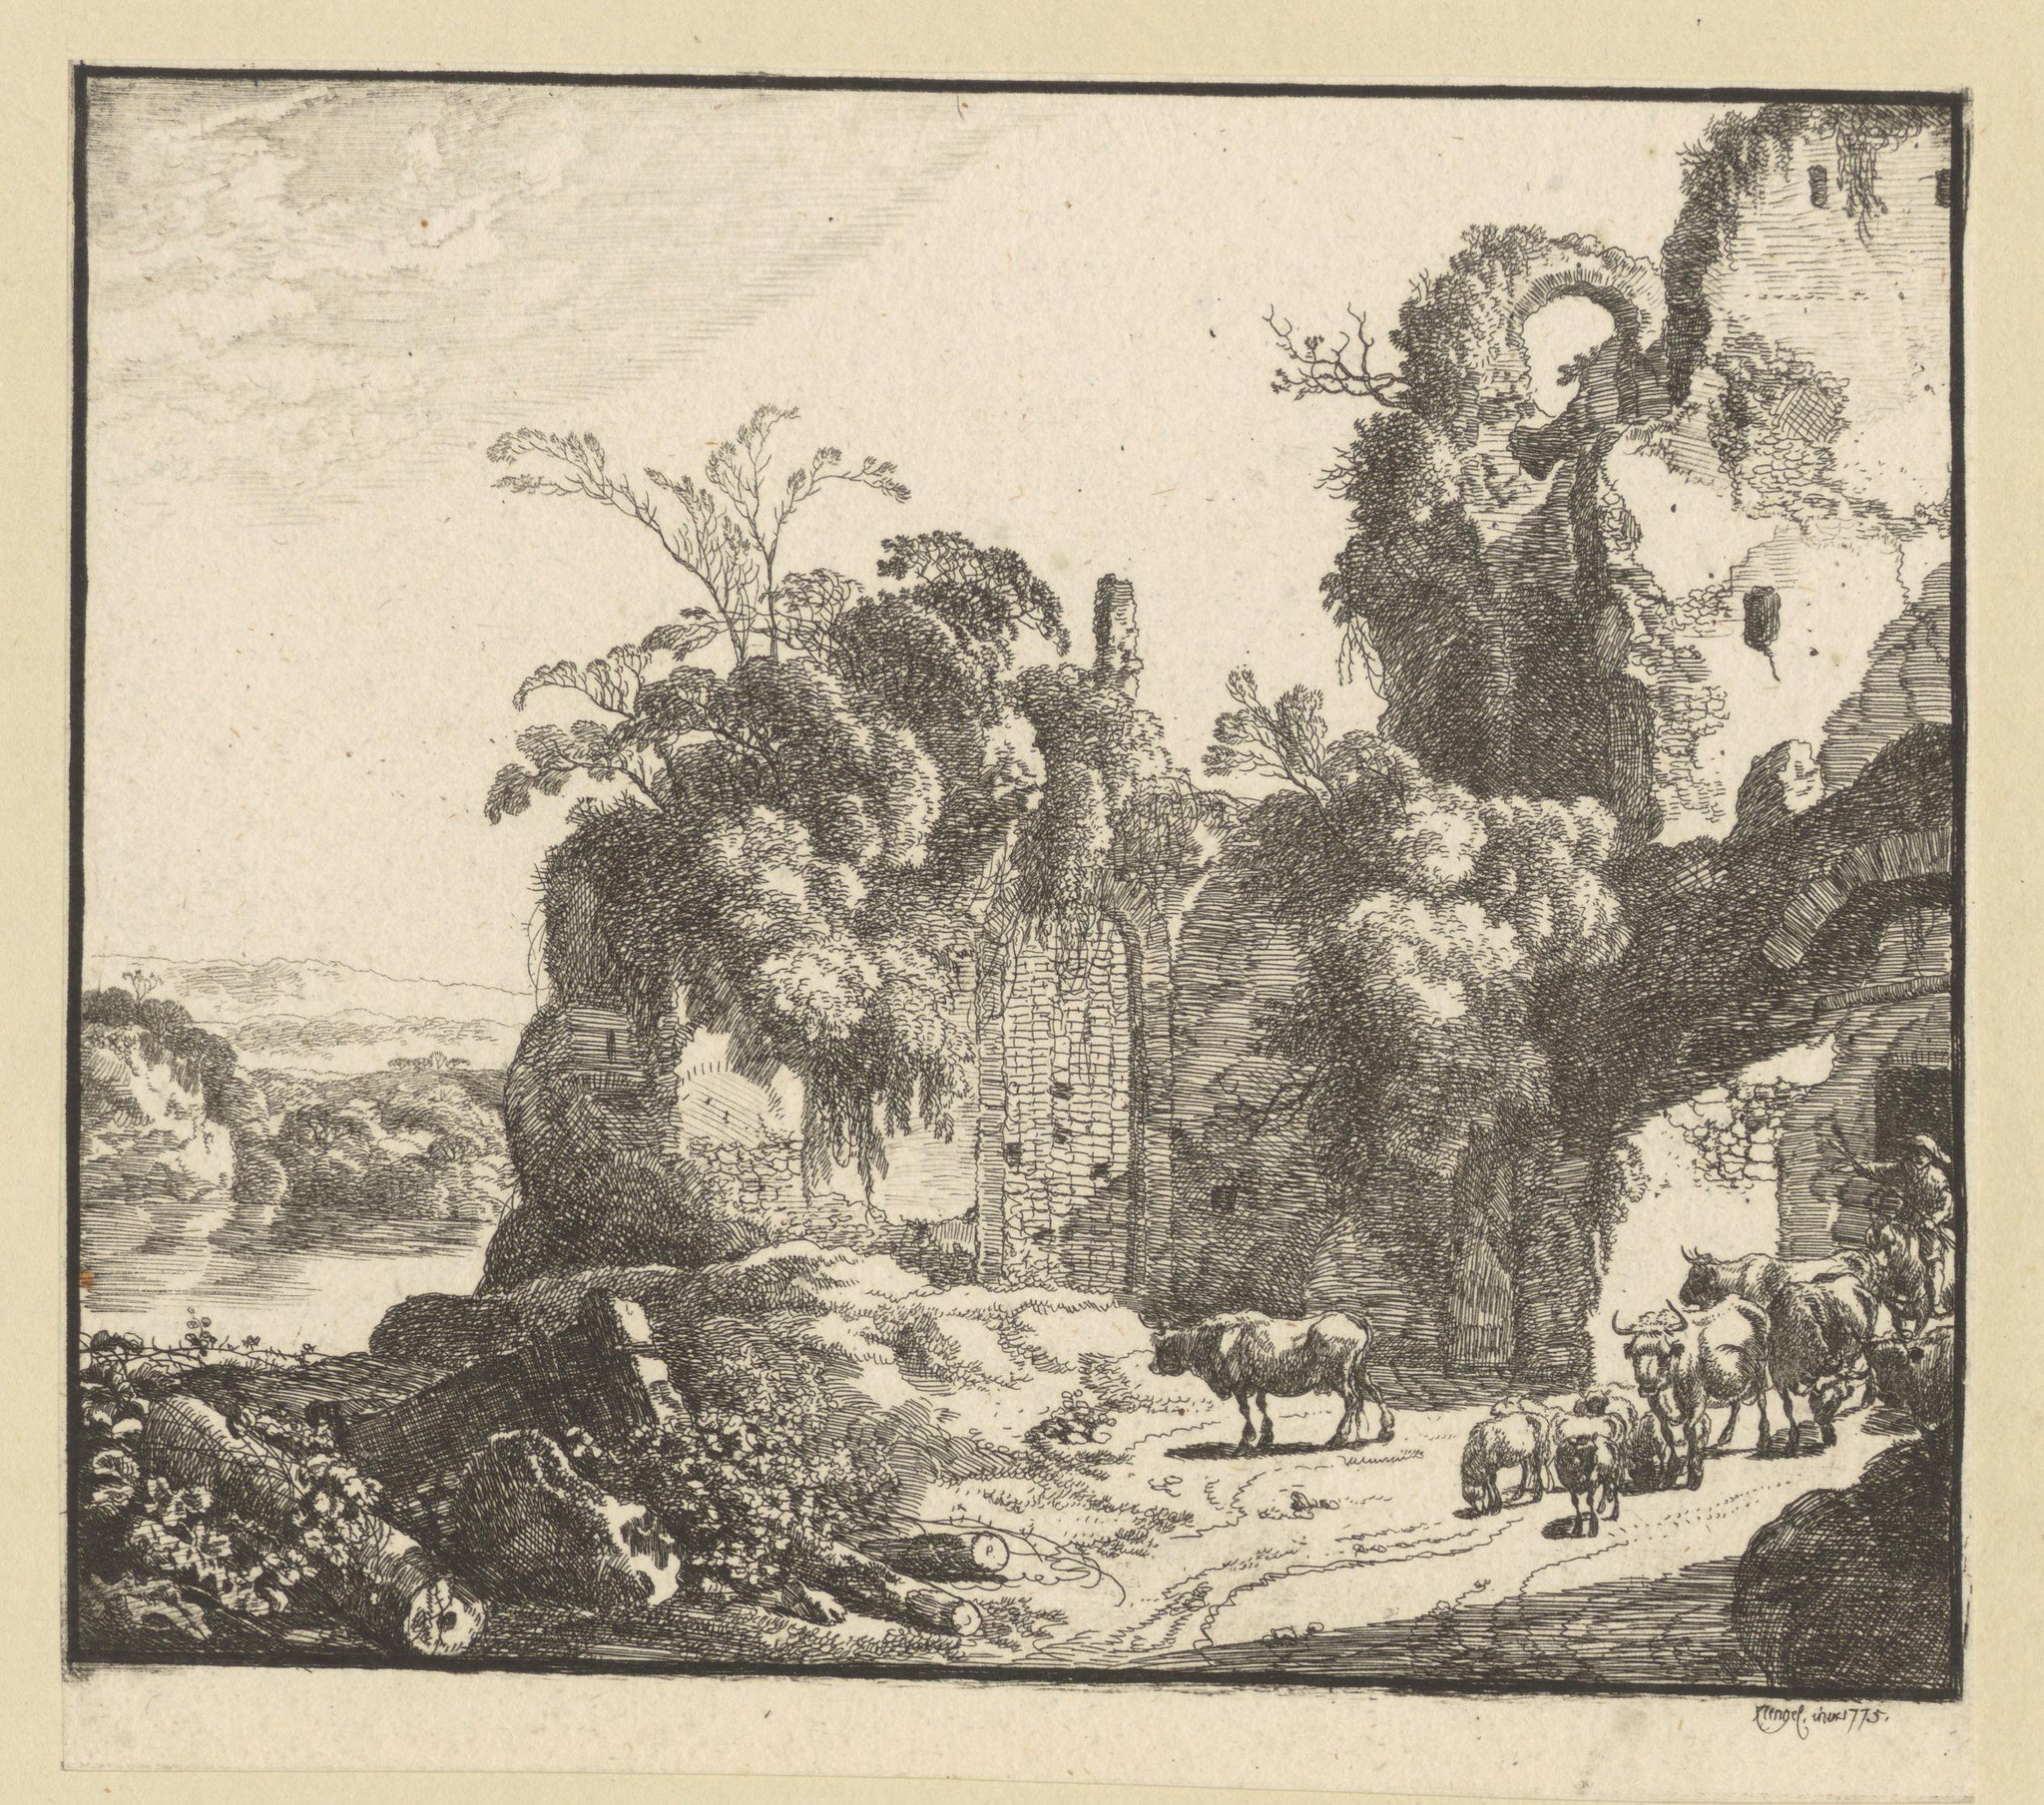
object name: print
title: Landschap met ruïne en een herder te paard met zijn kudde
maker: johann christian klengel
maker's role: print maker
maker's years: 1751-1824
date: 1775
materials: paper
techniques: etching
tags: herding, herdsman, herdswoman, shepherd, shepherdess, cowherd, etc., cattle, landscape with ruins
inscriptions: collector's mark: Lugt 240